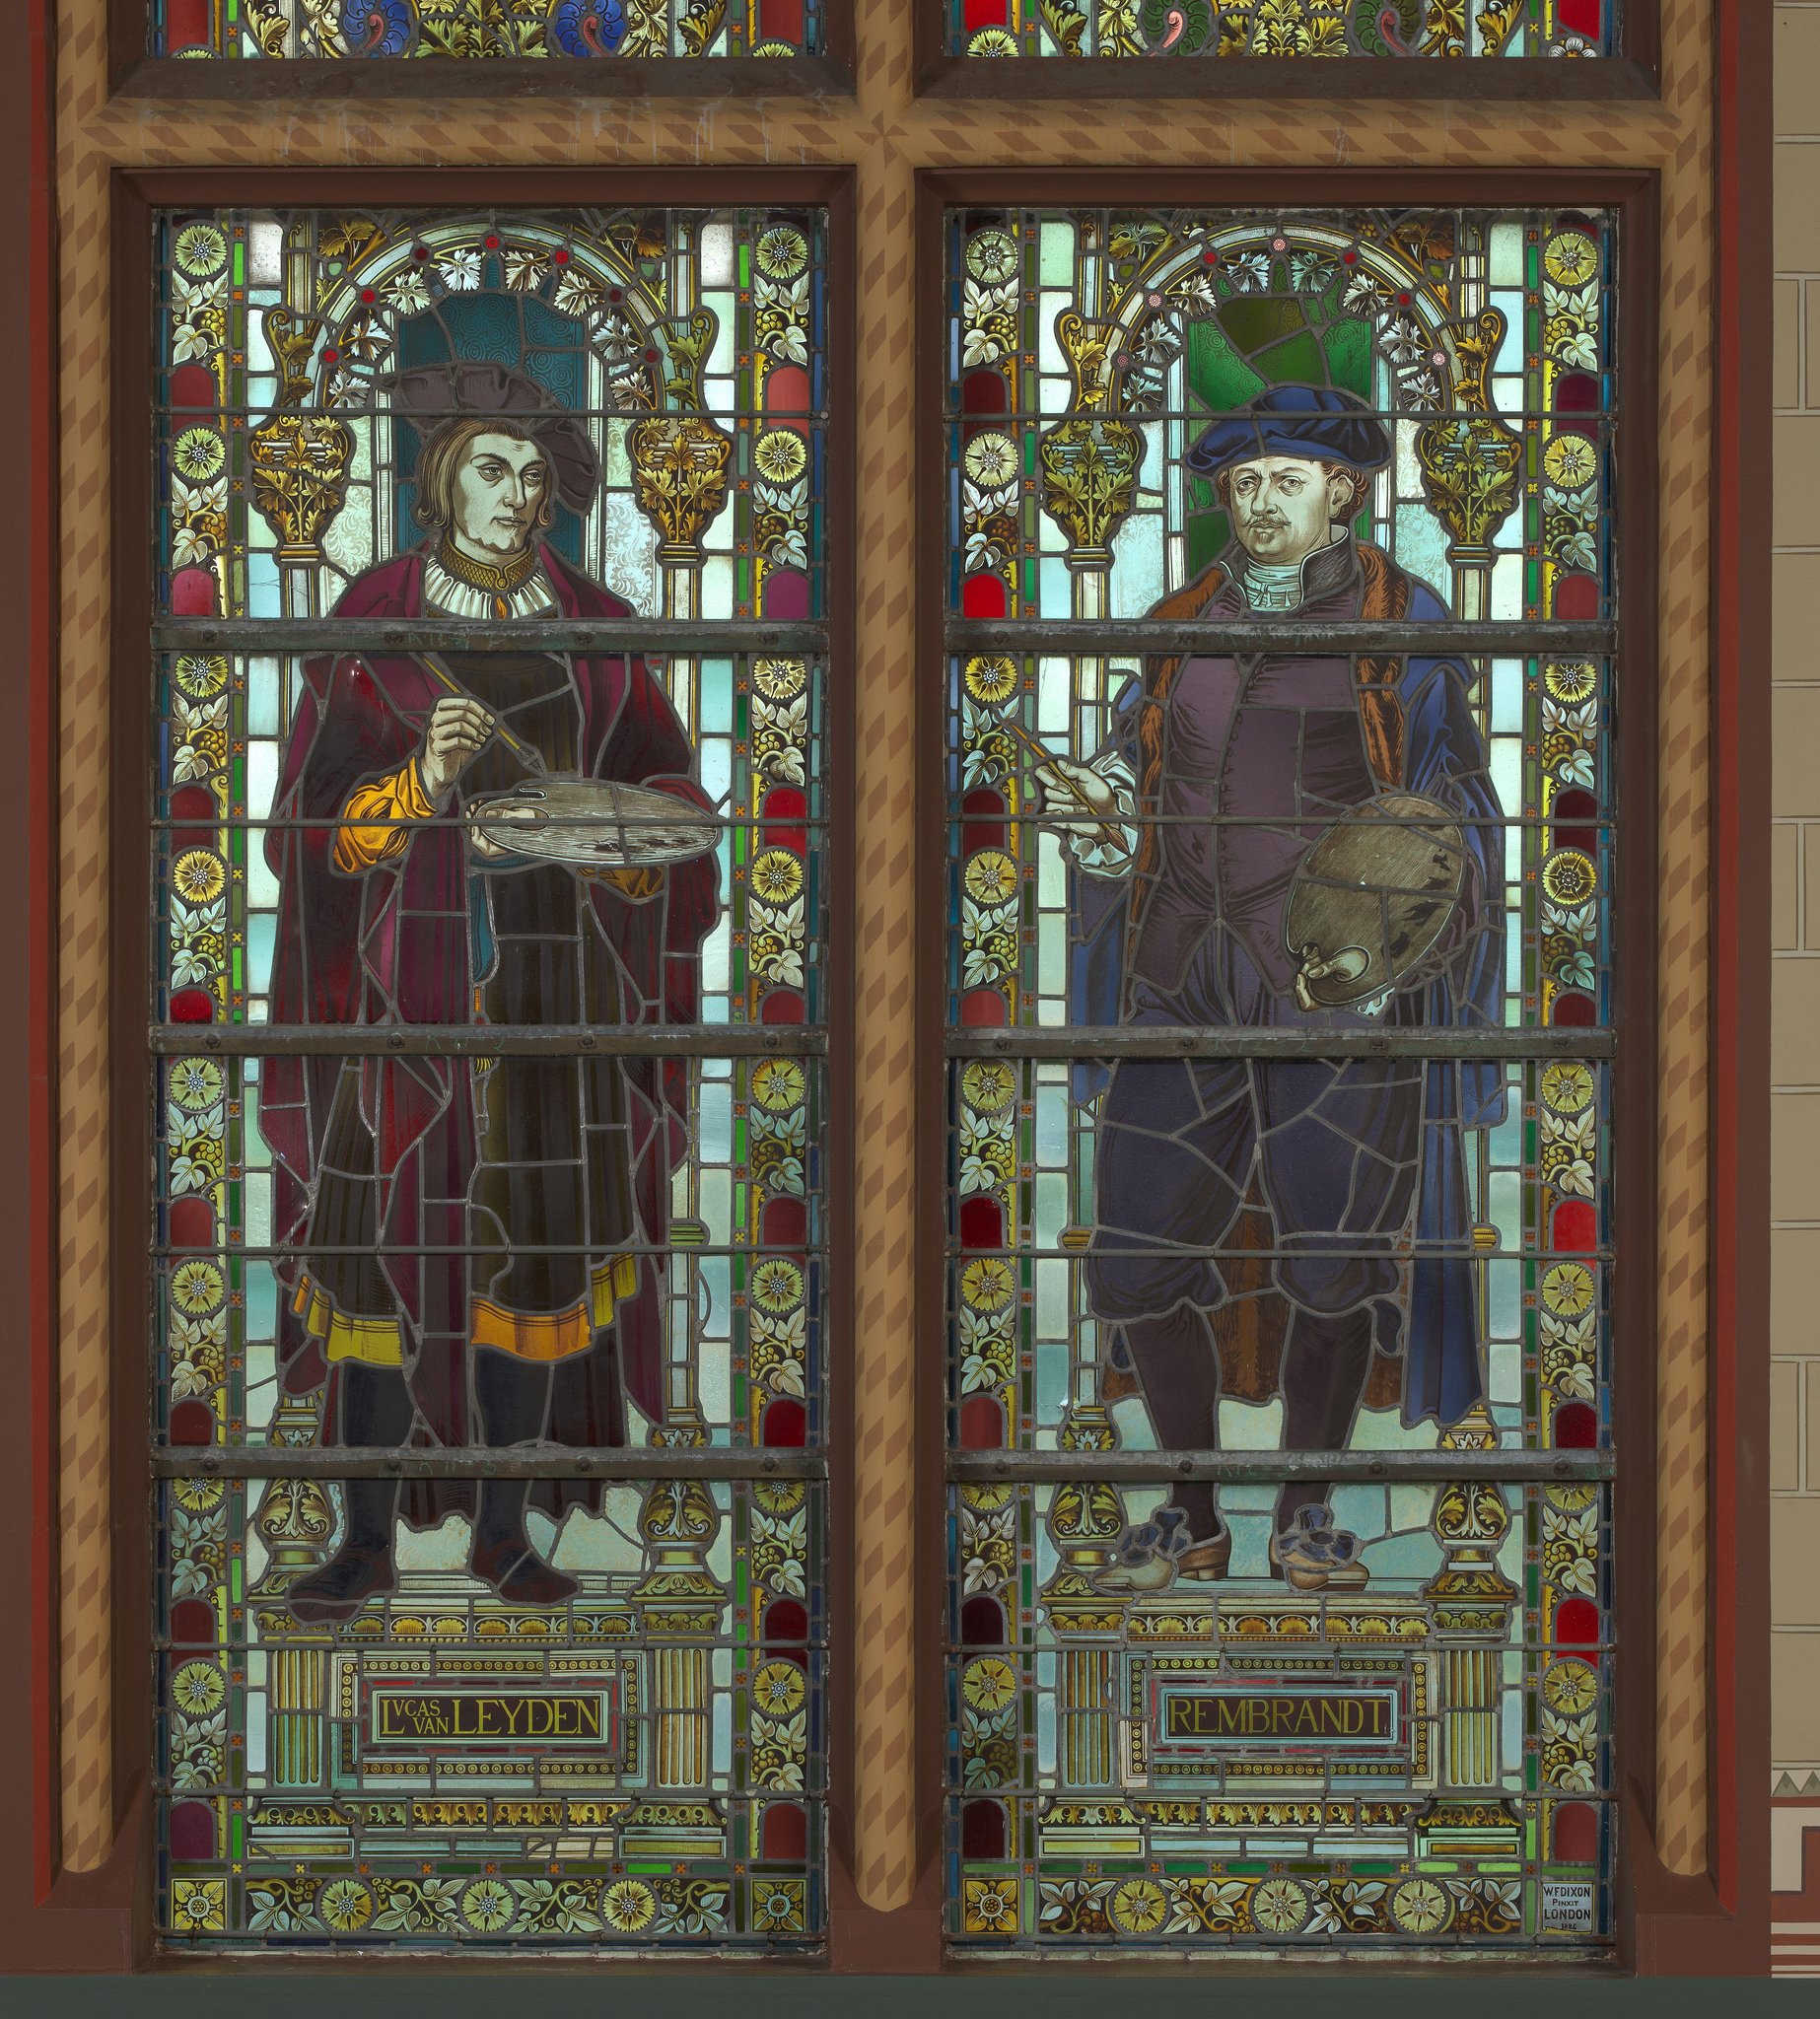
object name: light window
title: Raam met voorstelling van de schilder Rembrandt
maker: william francis dixon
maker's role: glasschilder, glazenier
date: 1883-1884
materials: glass, lead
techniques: leading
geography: england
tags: leiden, draughtsman, rembrandt van rijn